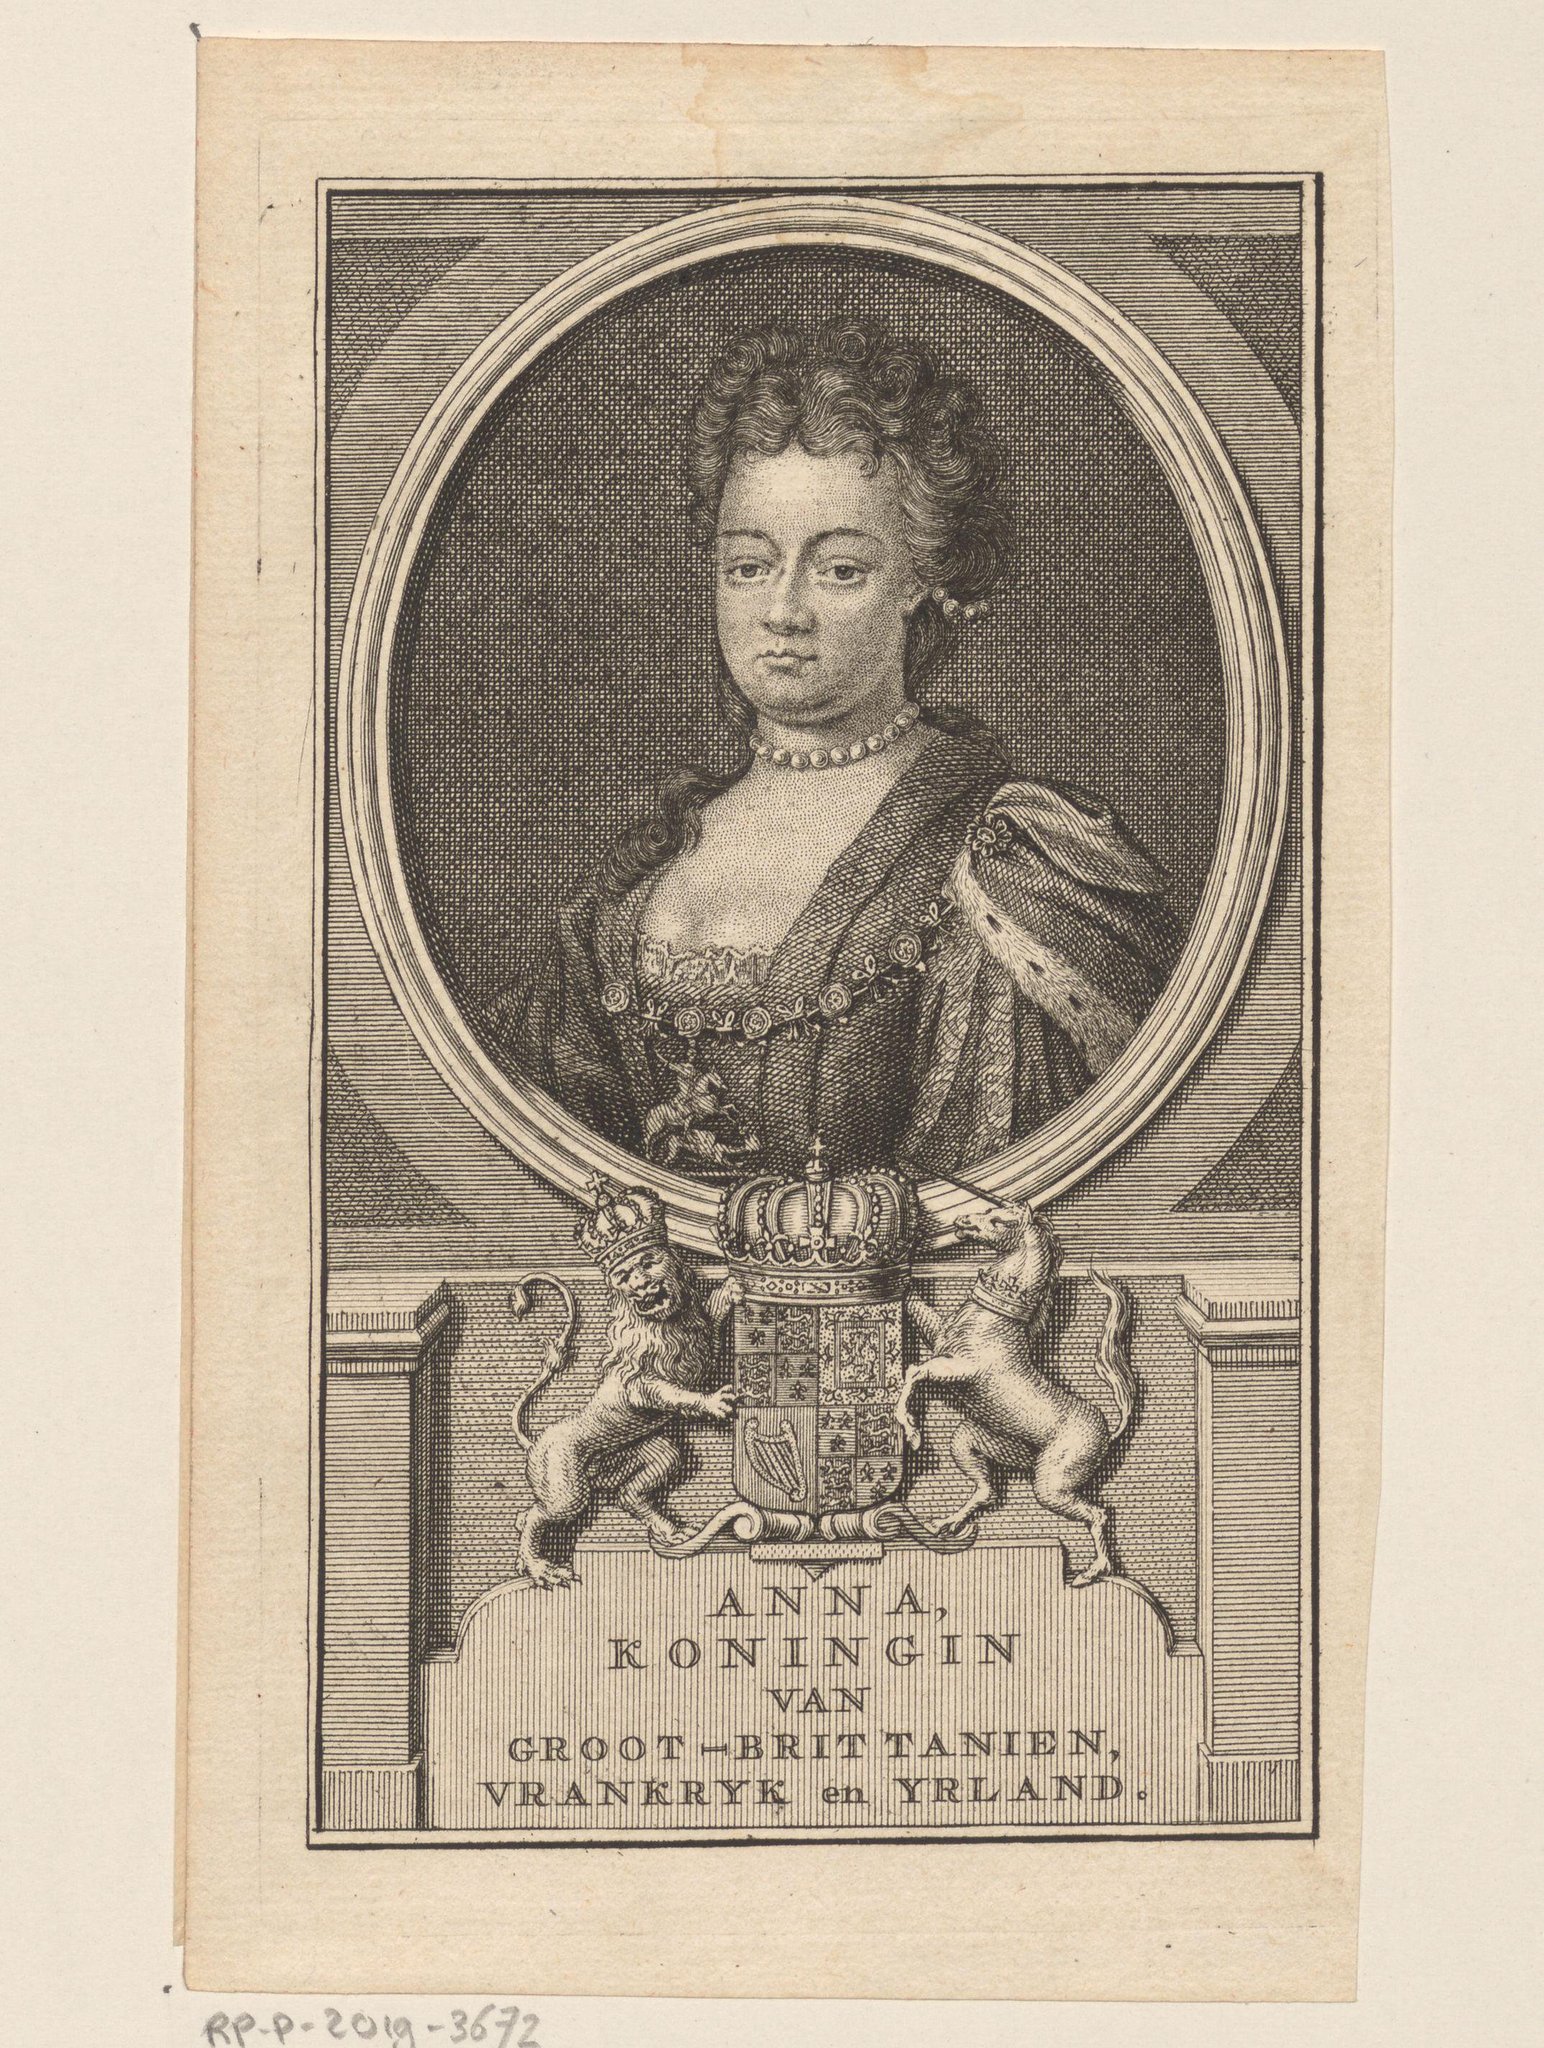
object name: book illustration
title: Portret van Anna Stuart, koningin van Groot-Brittannië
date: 1736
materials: paper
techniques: engraving, etching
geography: delft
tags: london, anna stuart (koningin van engeland en schotland), historical persons - bb - woman, armorial bearing, heraldry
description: Prent uit: Boyer, Abel. Het leven en de regering van Anna koningin van Engeland. 5 dln. Delft: Reinier Boitet, 1736-1737.